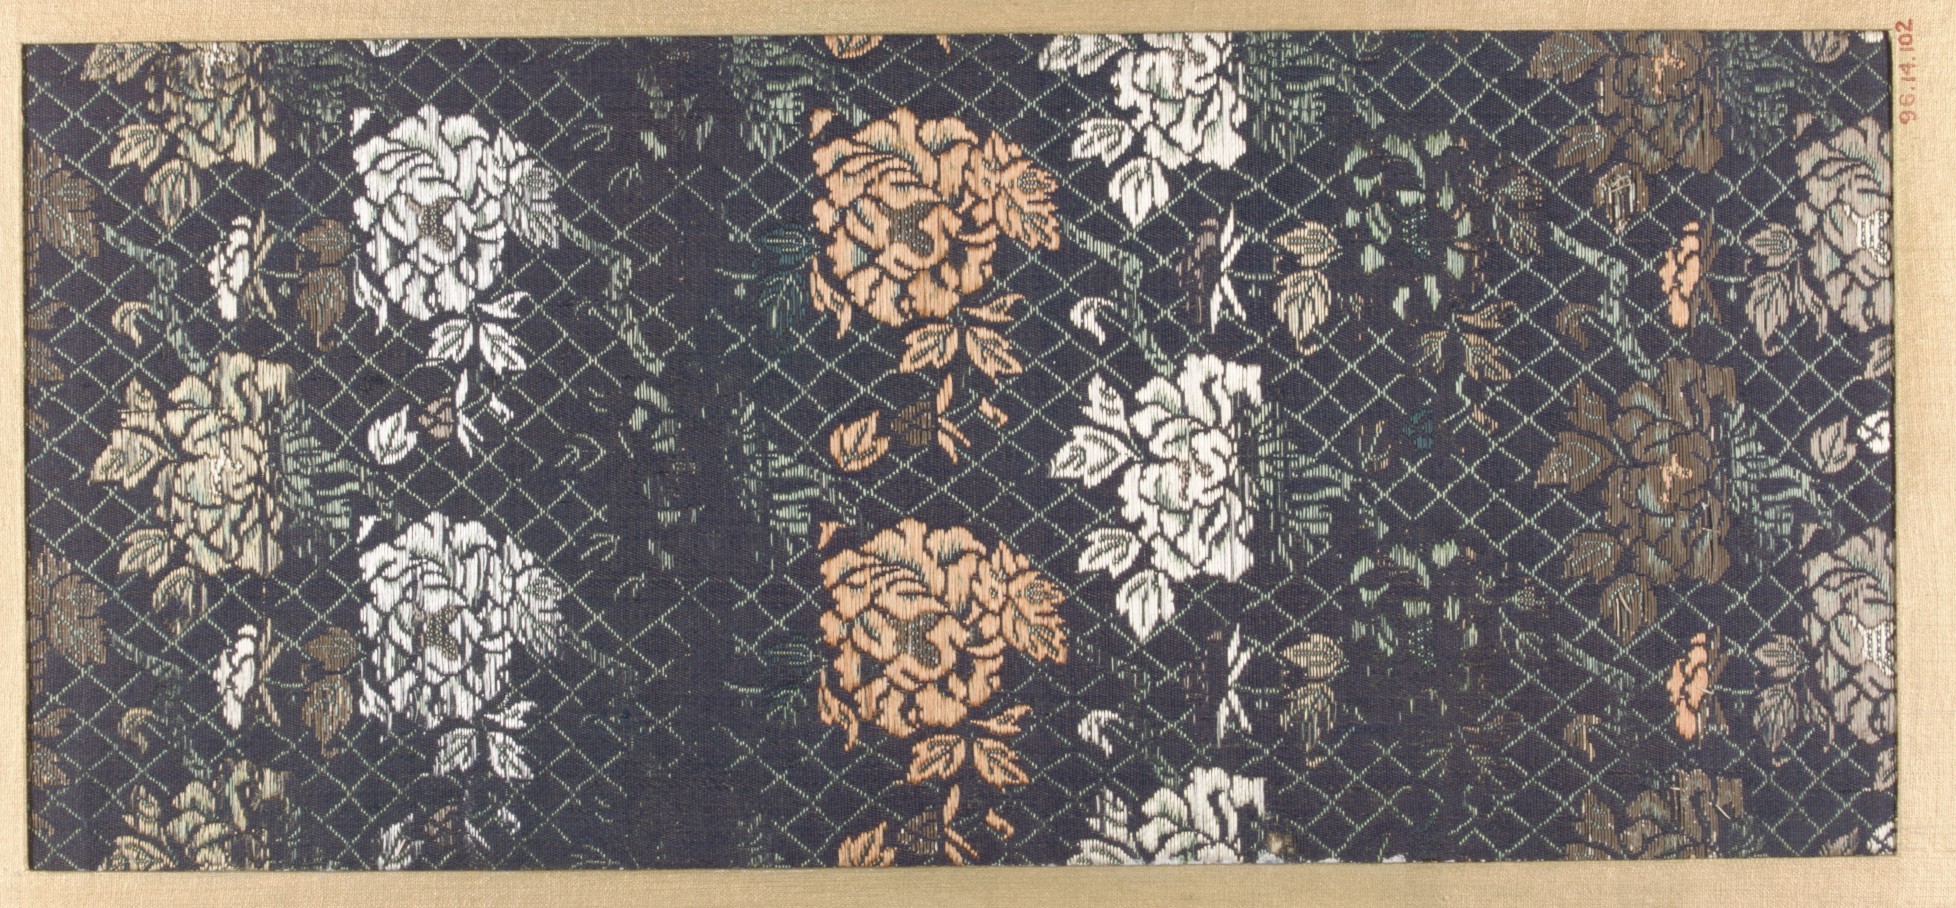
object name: piece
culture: japanese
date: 1701-1900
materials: silk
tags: flowers